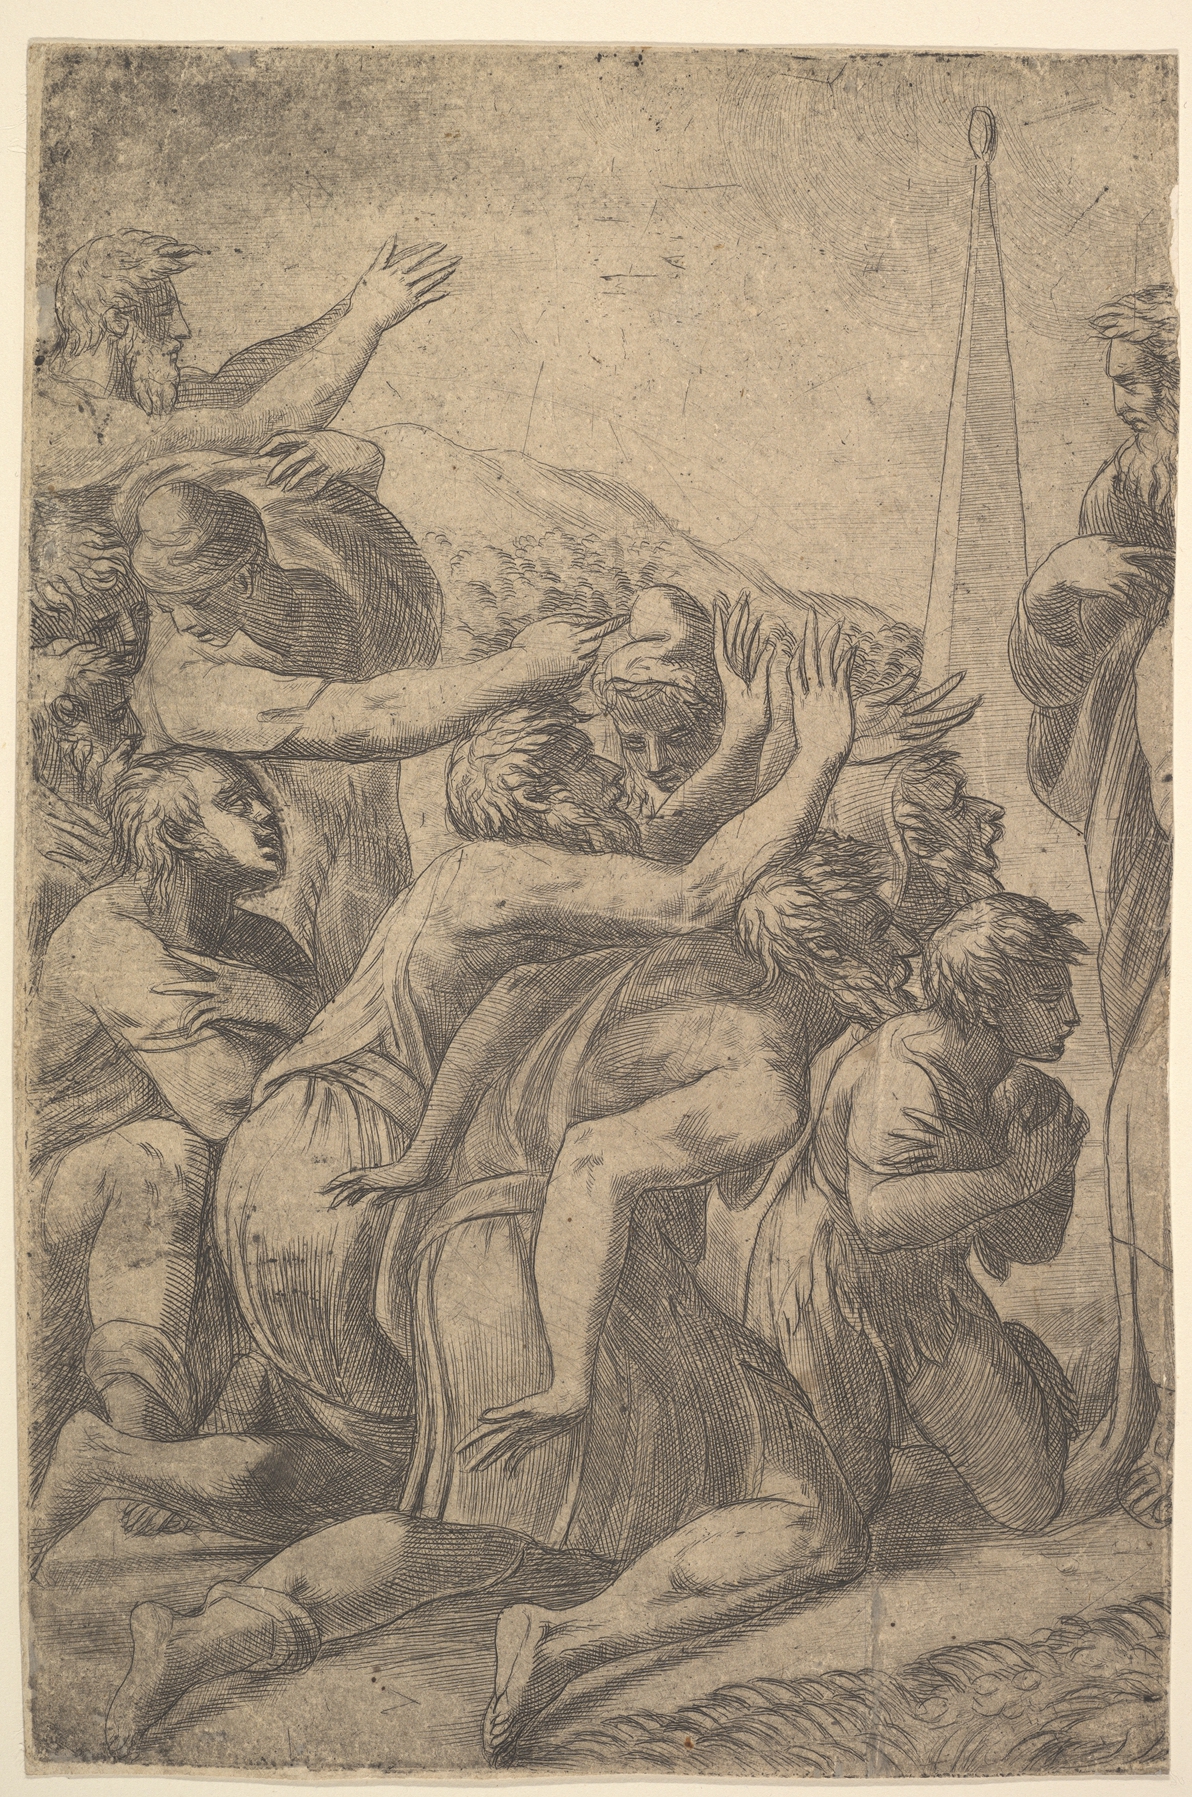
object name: print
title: Christ standing at the right healing the lepers before him (left section of the print)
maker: andrea schiavone (andrea meldola)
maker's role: artist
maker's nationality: italian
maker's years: 1510-1563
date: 1545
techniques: etching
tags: obelisks,men,christ